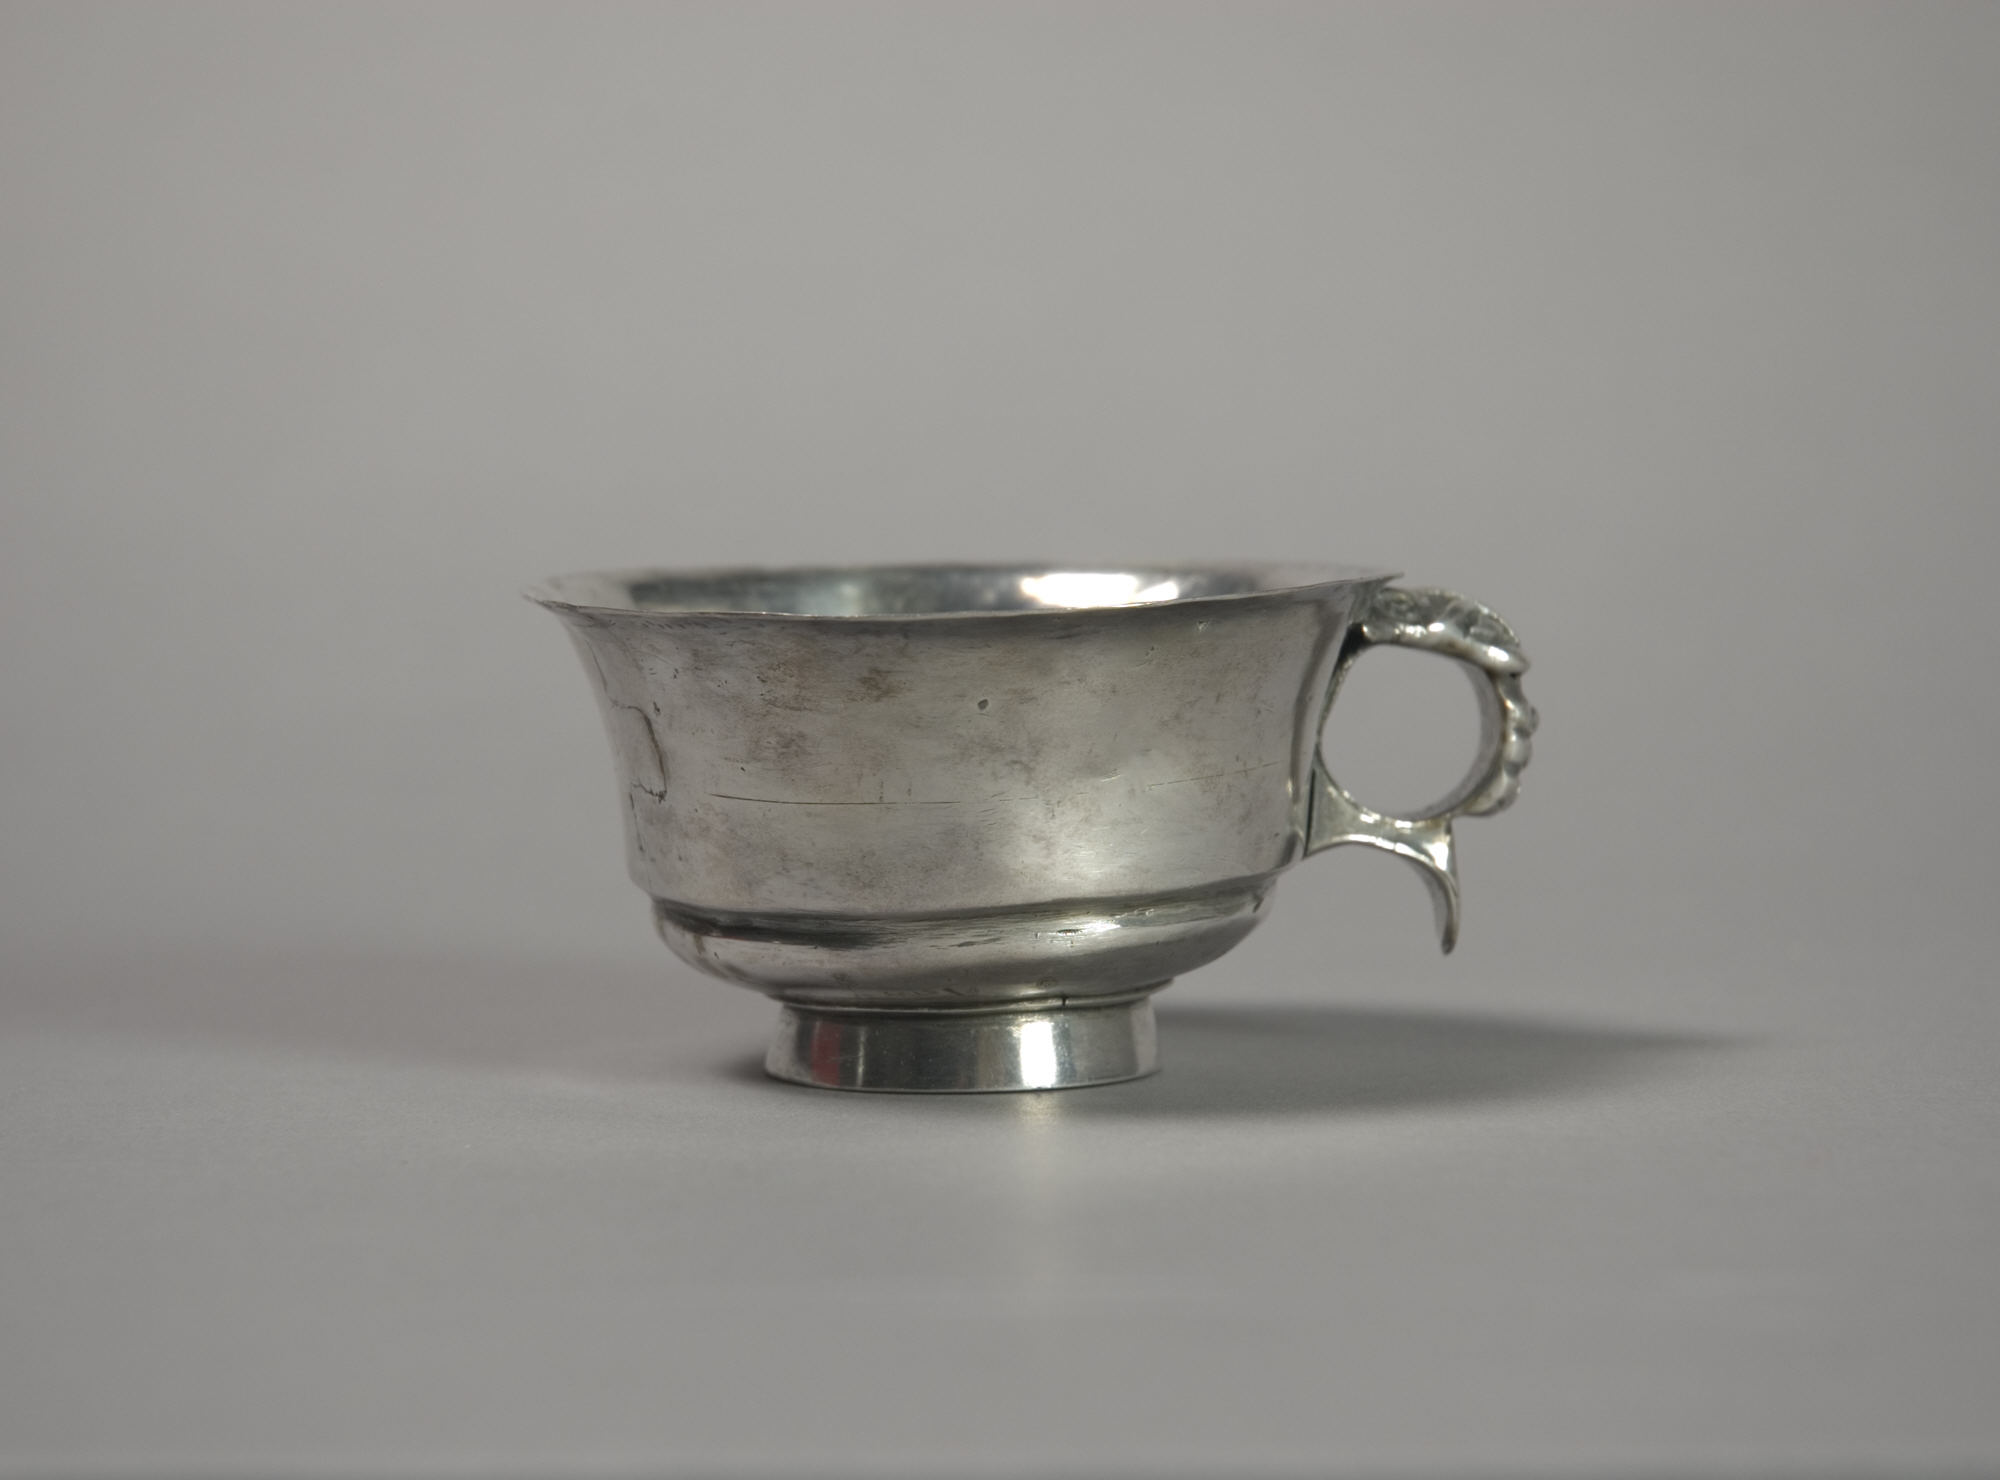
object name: cup with handle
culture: central asian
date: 501-700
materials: silver